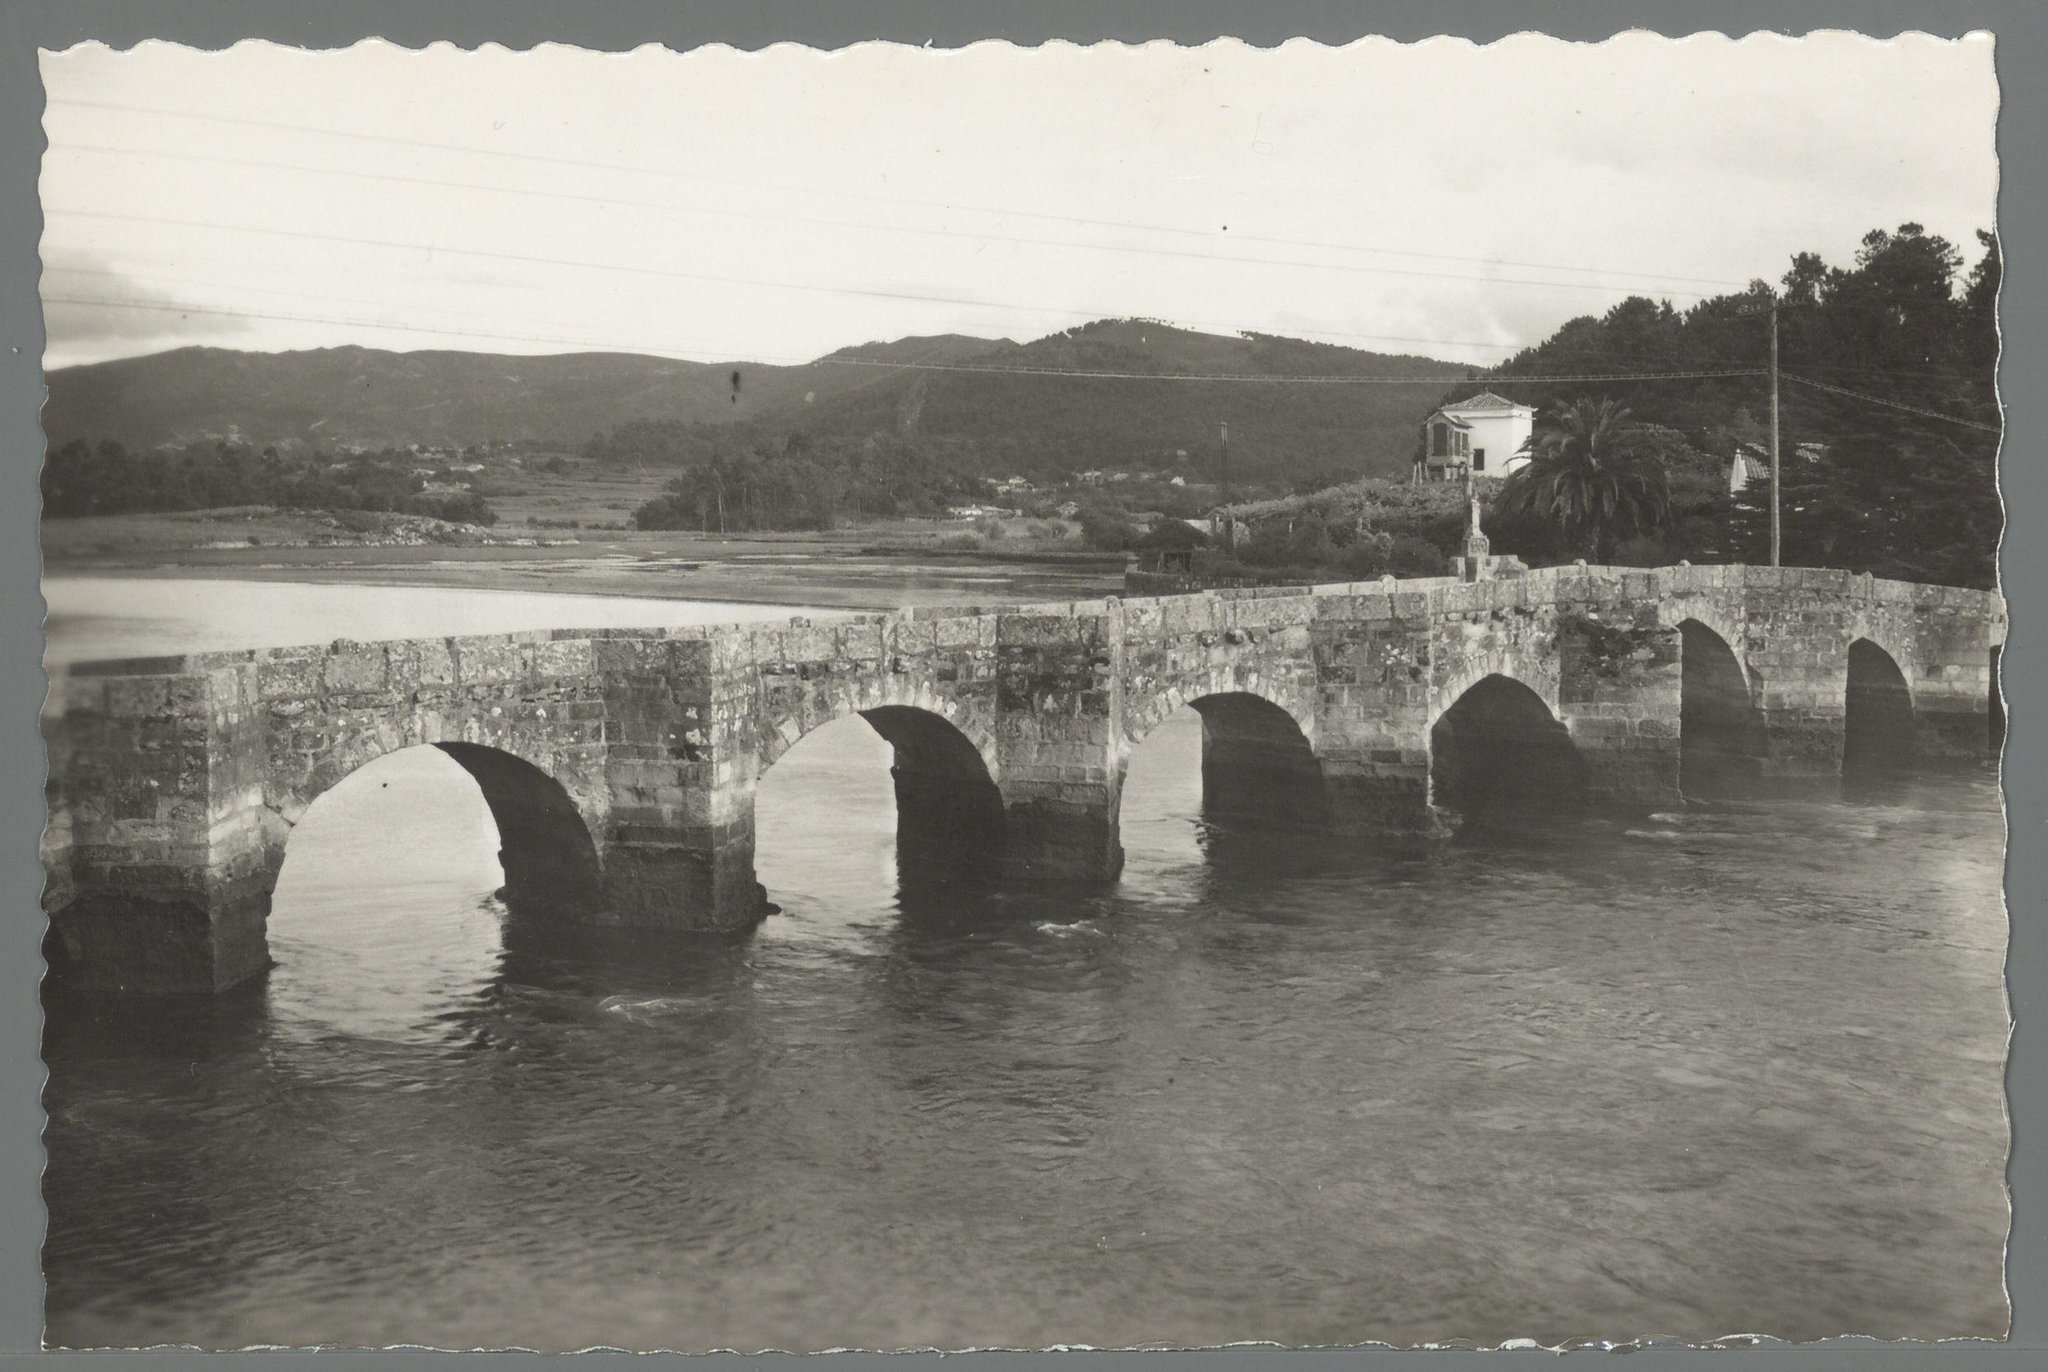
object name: photograph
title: Bayona (Pontevedra). Puente románico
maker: luis garcía garrabella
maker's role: publisher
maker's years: -1977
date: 1939-1950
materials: photographic support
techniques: photography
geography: zaragoza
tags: landscape with bridge, viaduct or aqueduct